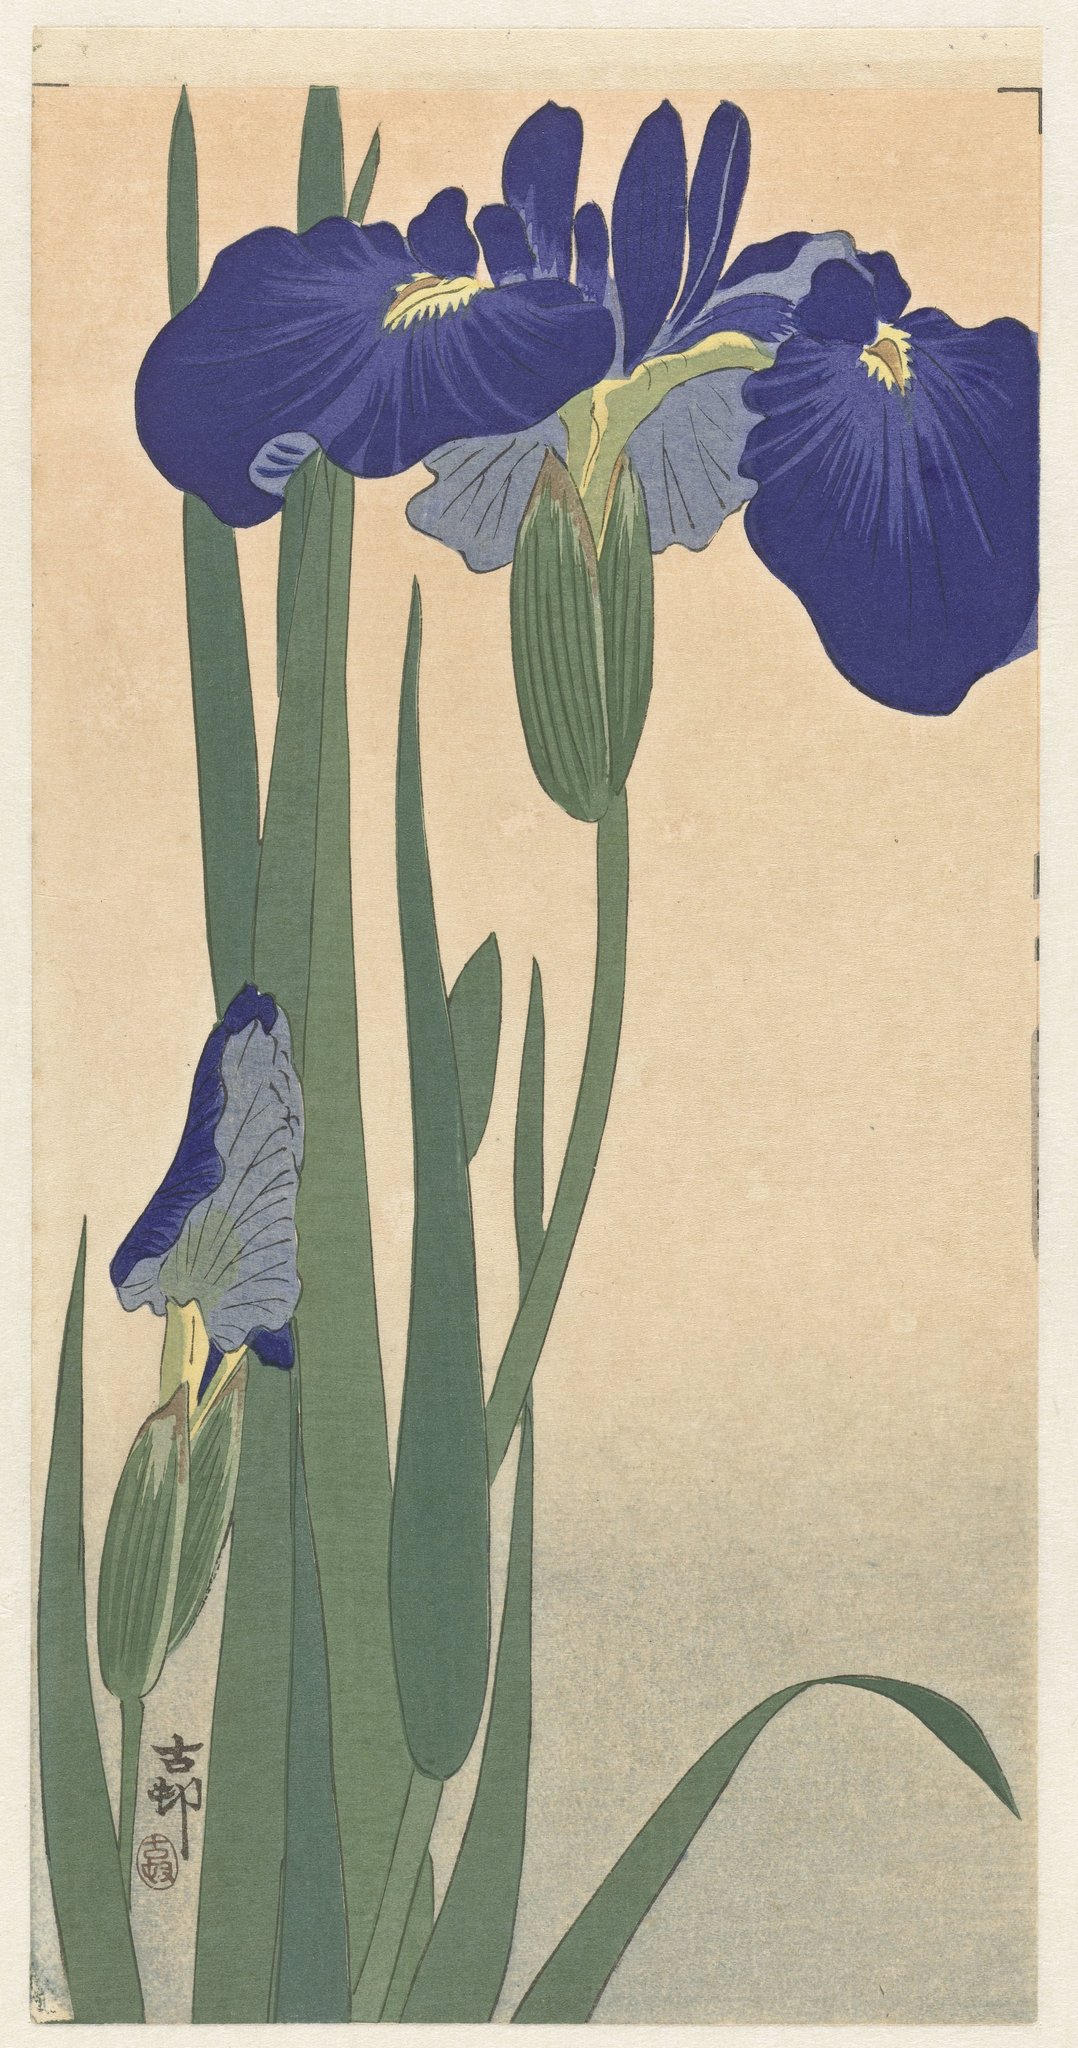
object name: print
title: Blue Irises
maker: ohara koson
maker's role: print maker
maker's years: 1877-1945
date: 1900-1930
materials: paper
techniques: woodcut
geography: japan